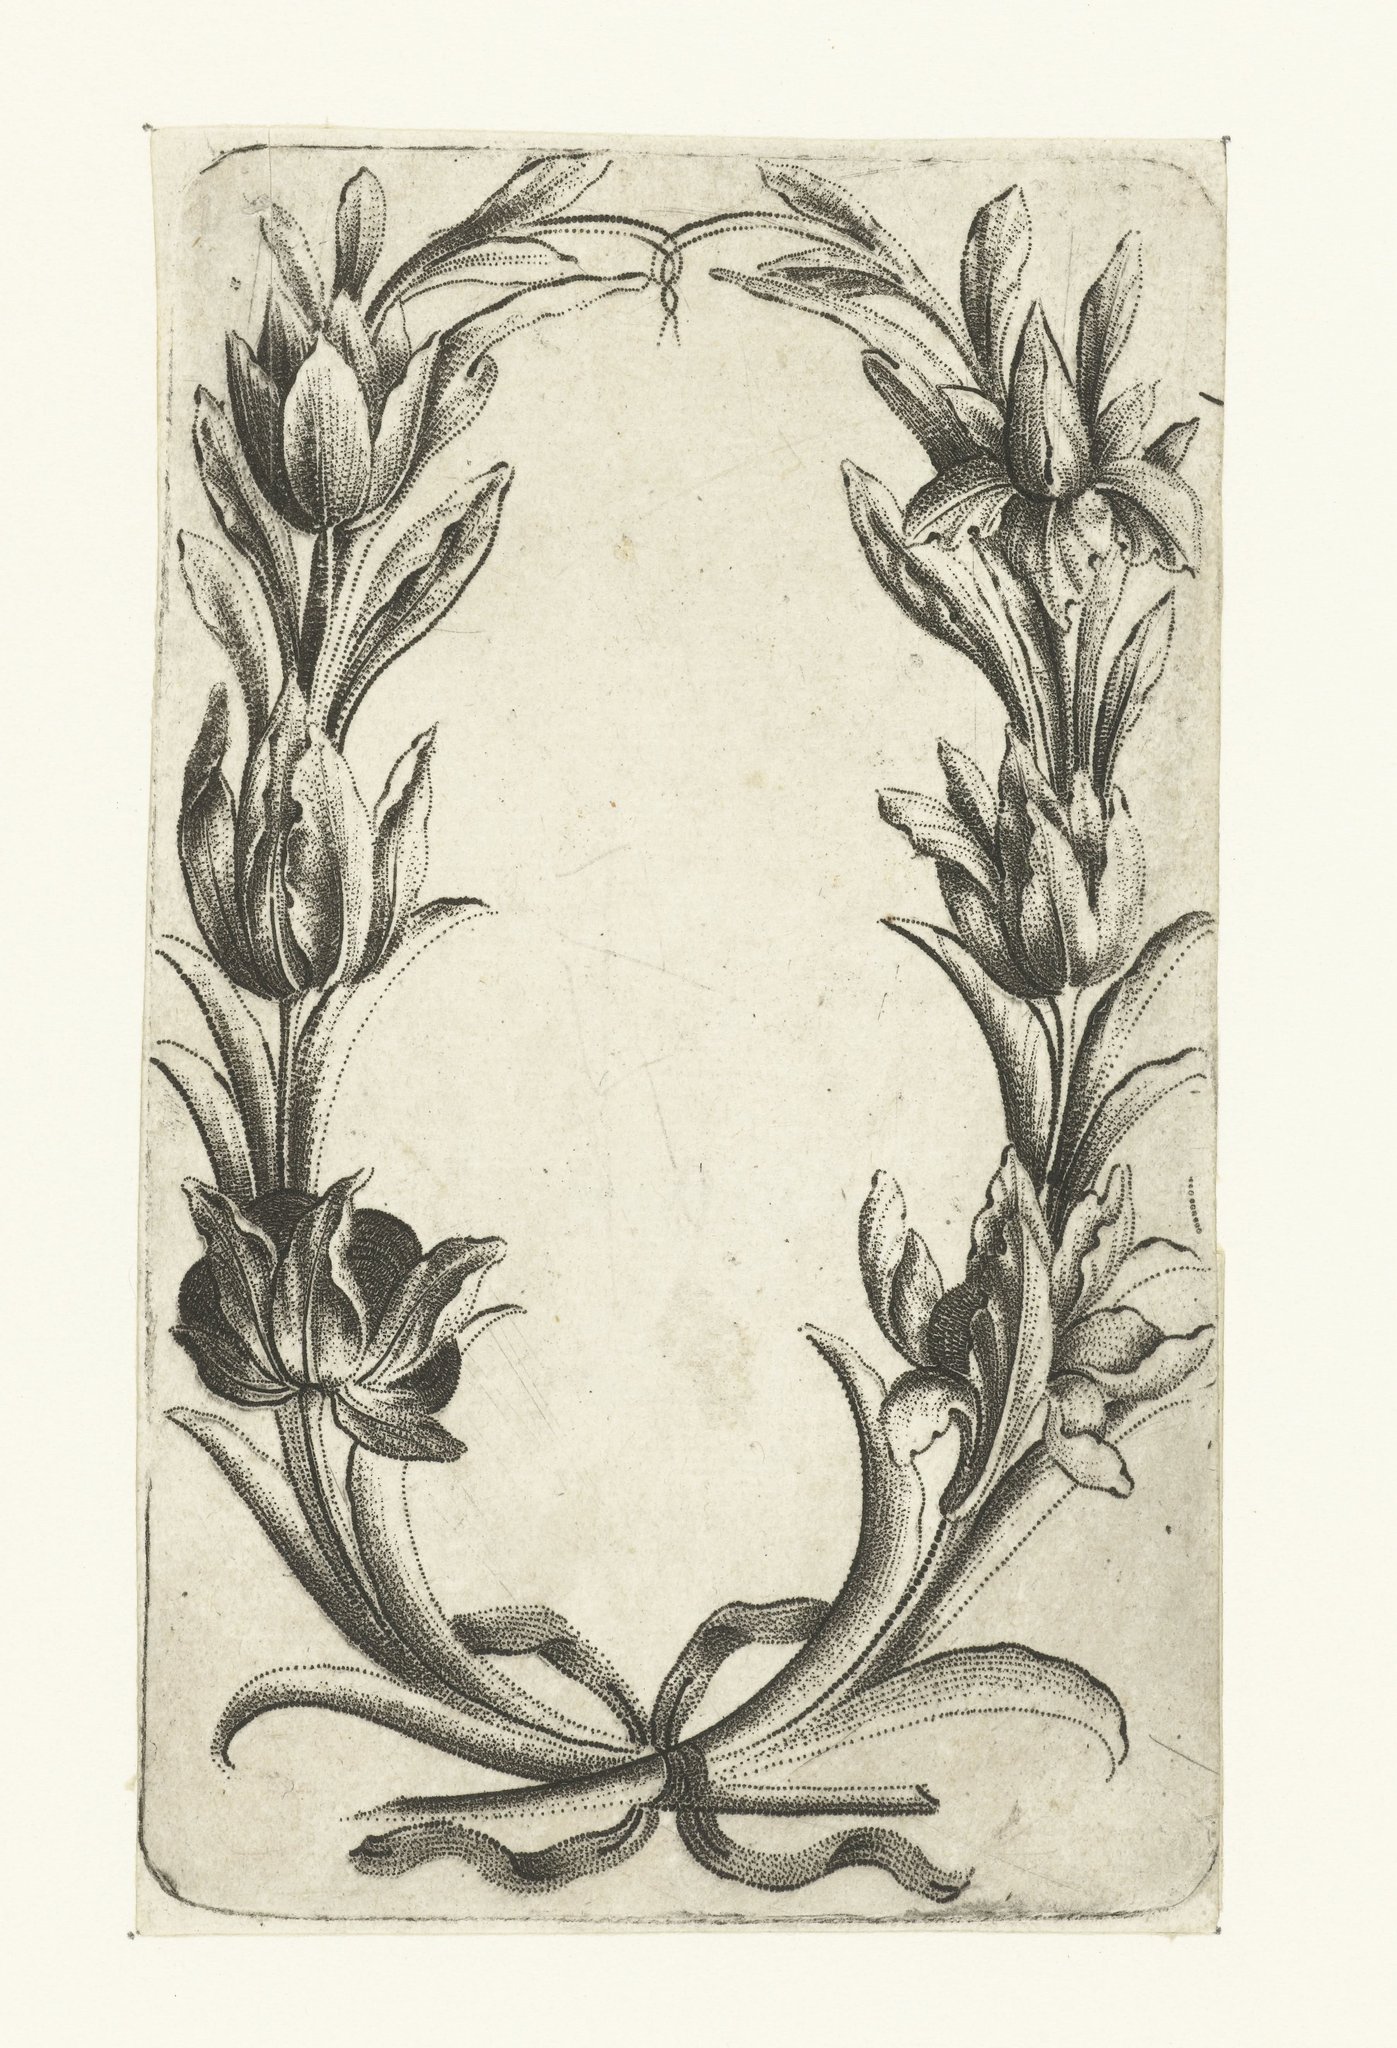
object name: print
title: Cartouche gevormd door twee ranken met irissen en tulpen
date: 1650-1660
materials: paper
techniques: etching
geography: amsterdam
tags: flowers, ornament ~ cartouche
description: De ranken zijn onderaan met een lint samen gebonden.